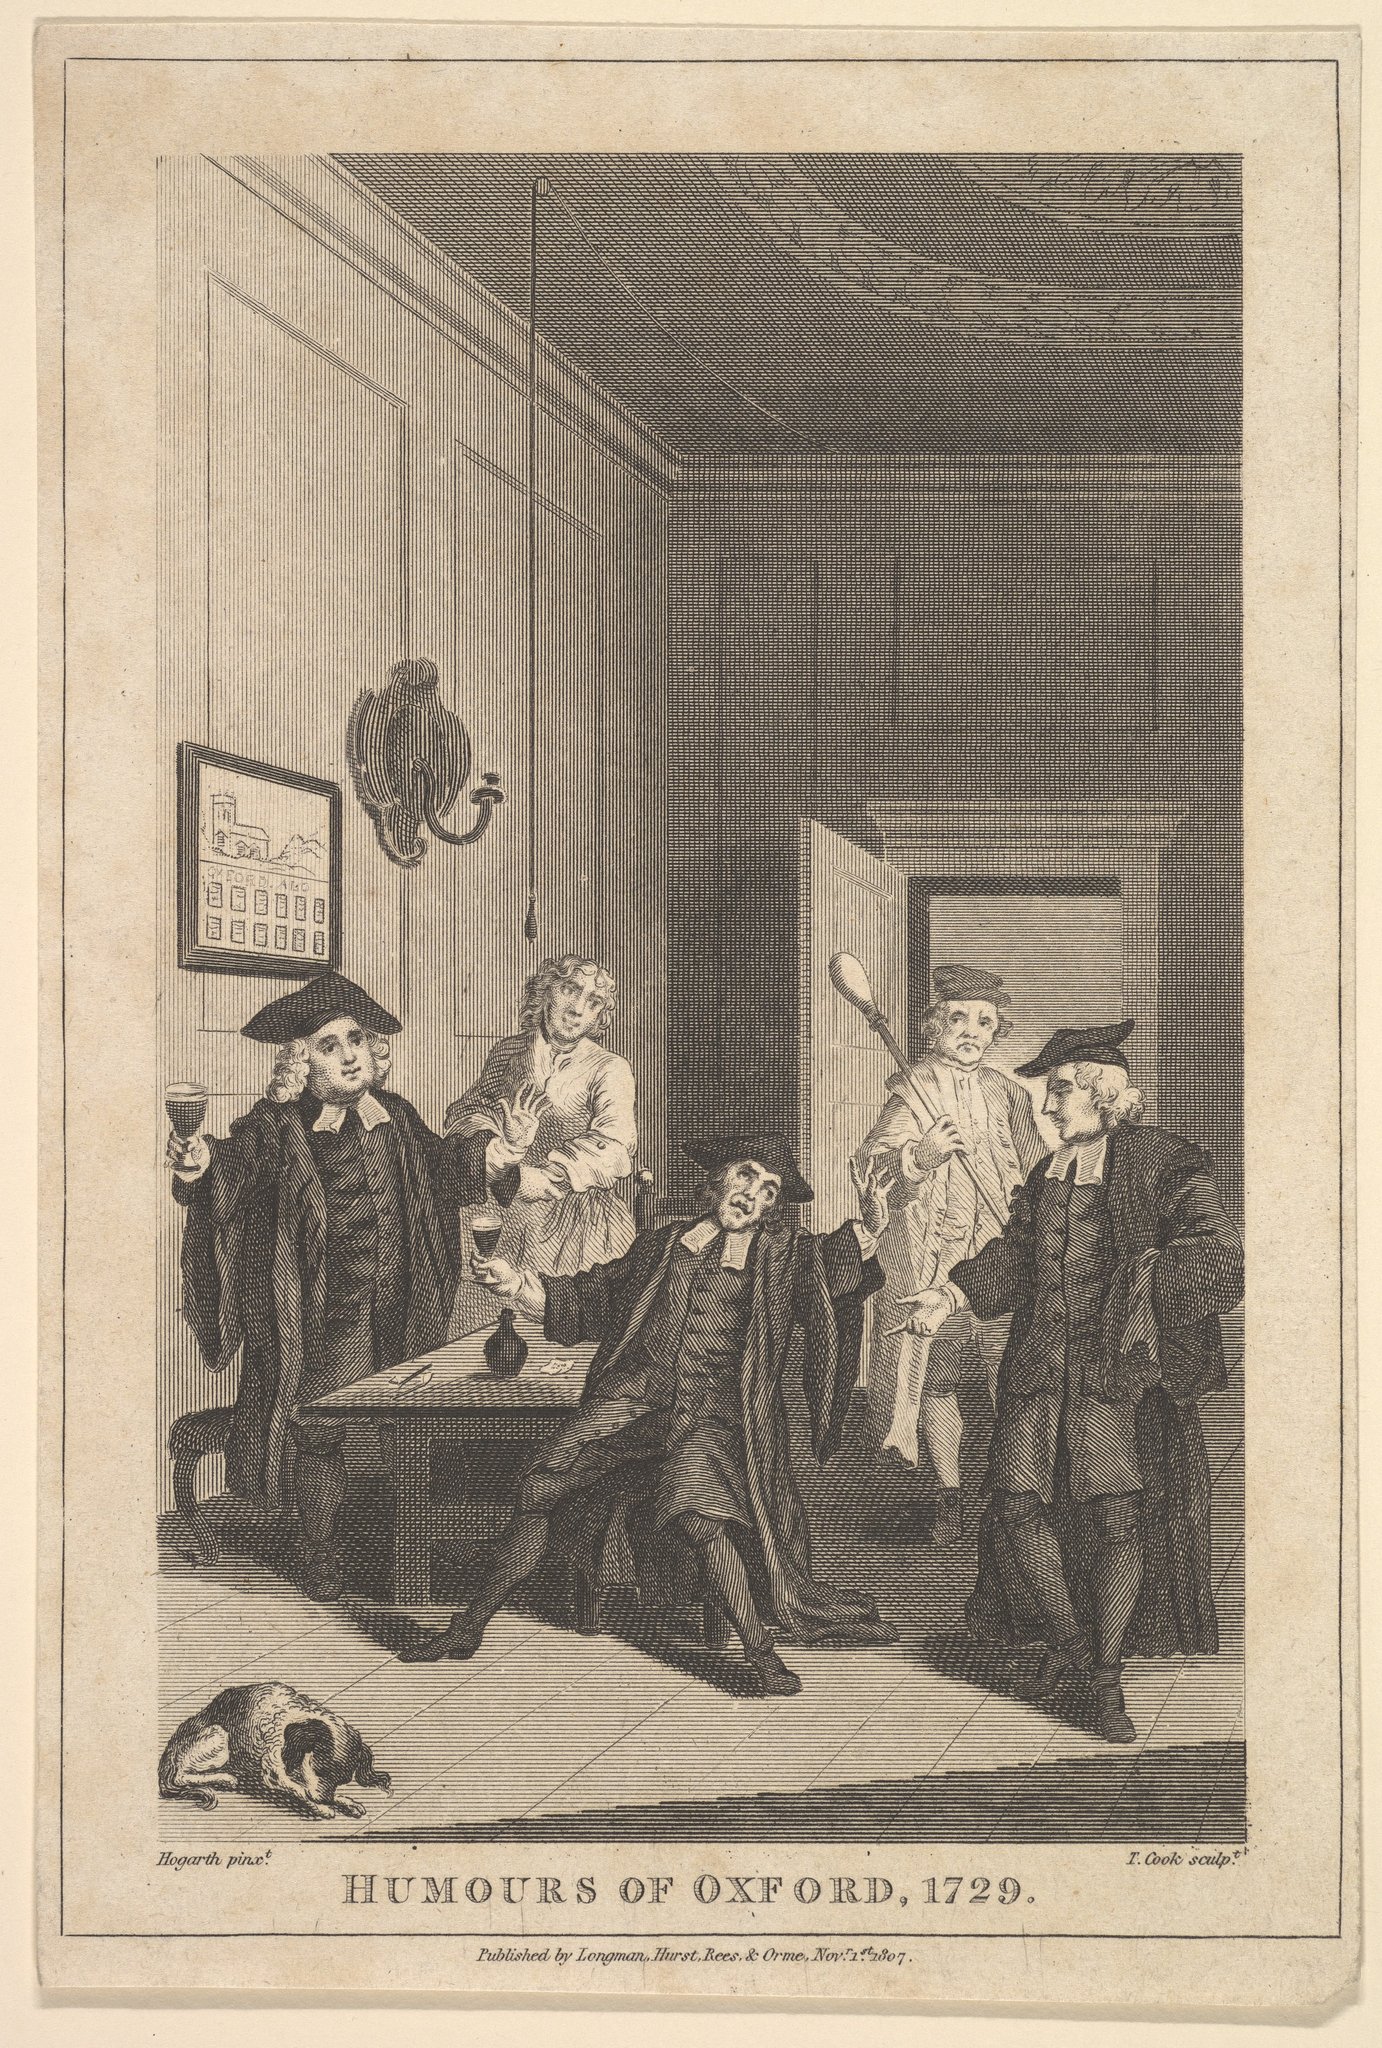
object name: print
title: Frontispiece to "The Humours of Oxford"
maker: william hogarth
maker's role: artist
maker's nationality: british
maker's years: 1697-1764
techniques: engraving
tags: men,dogs,drinking